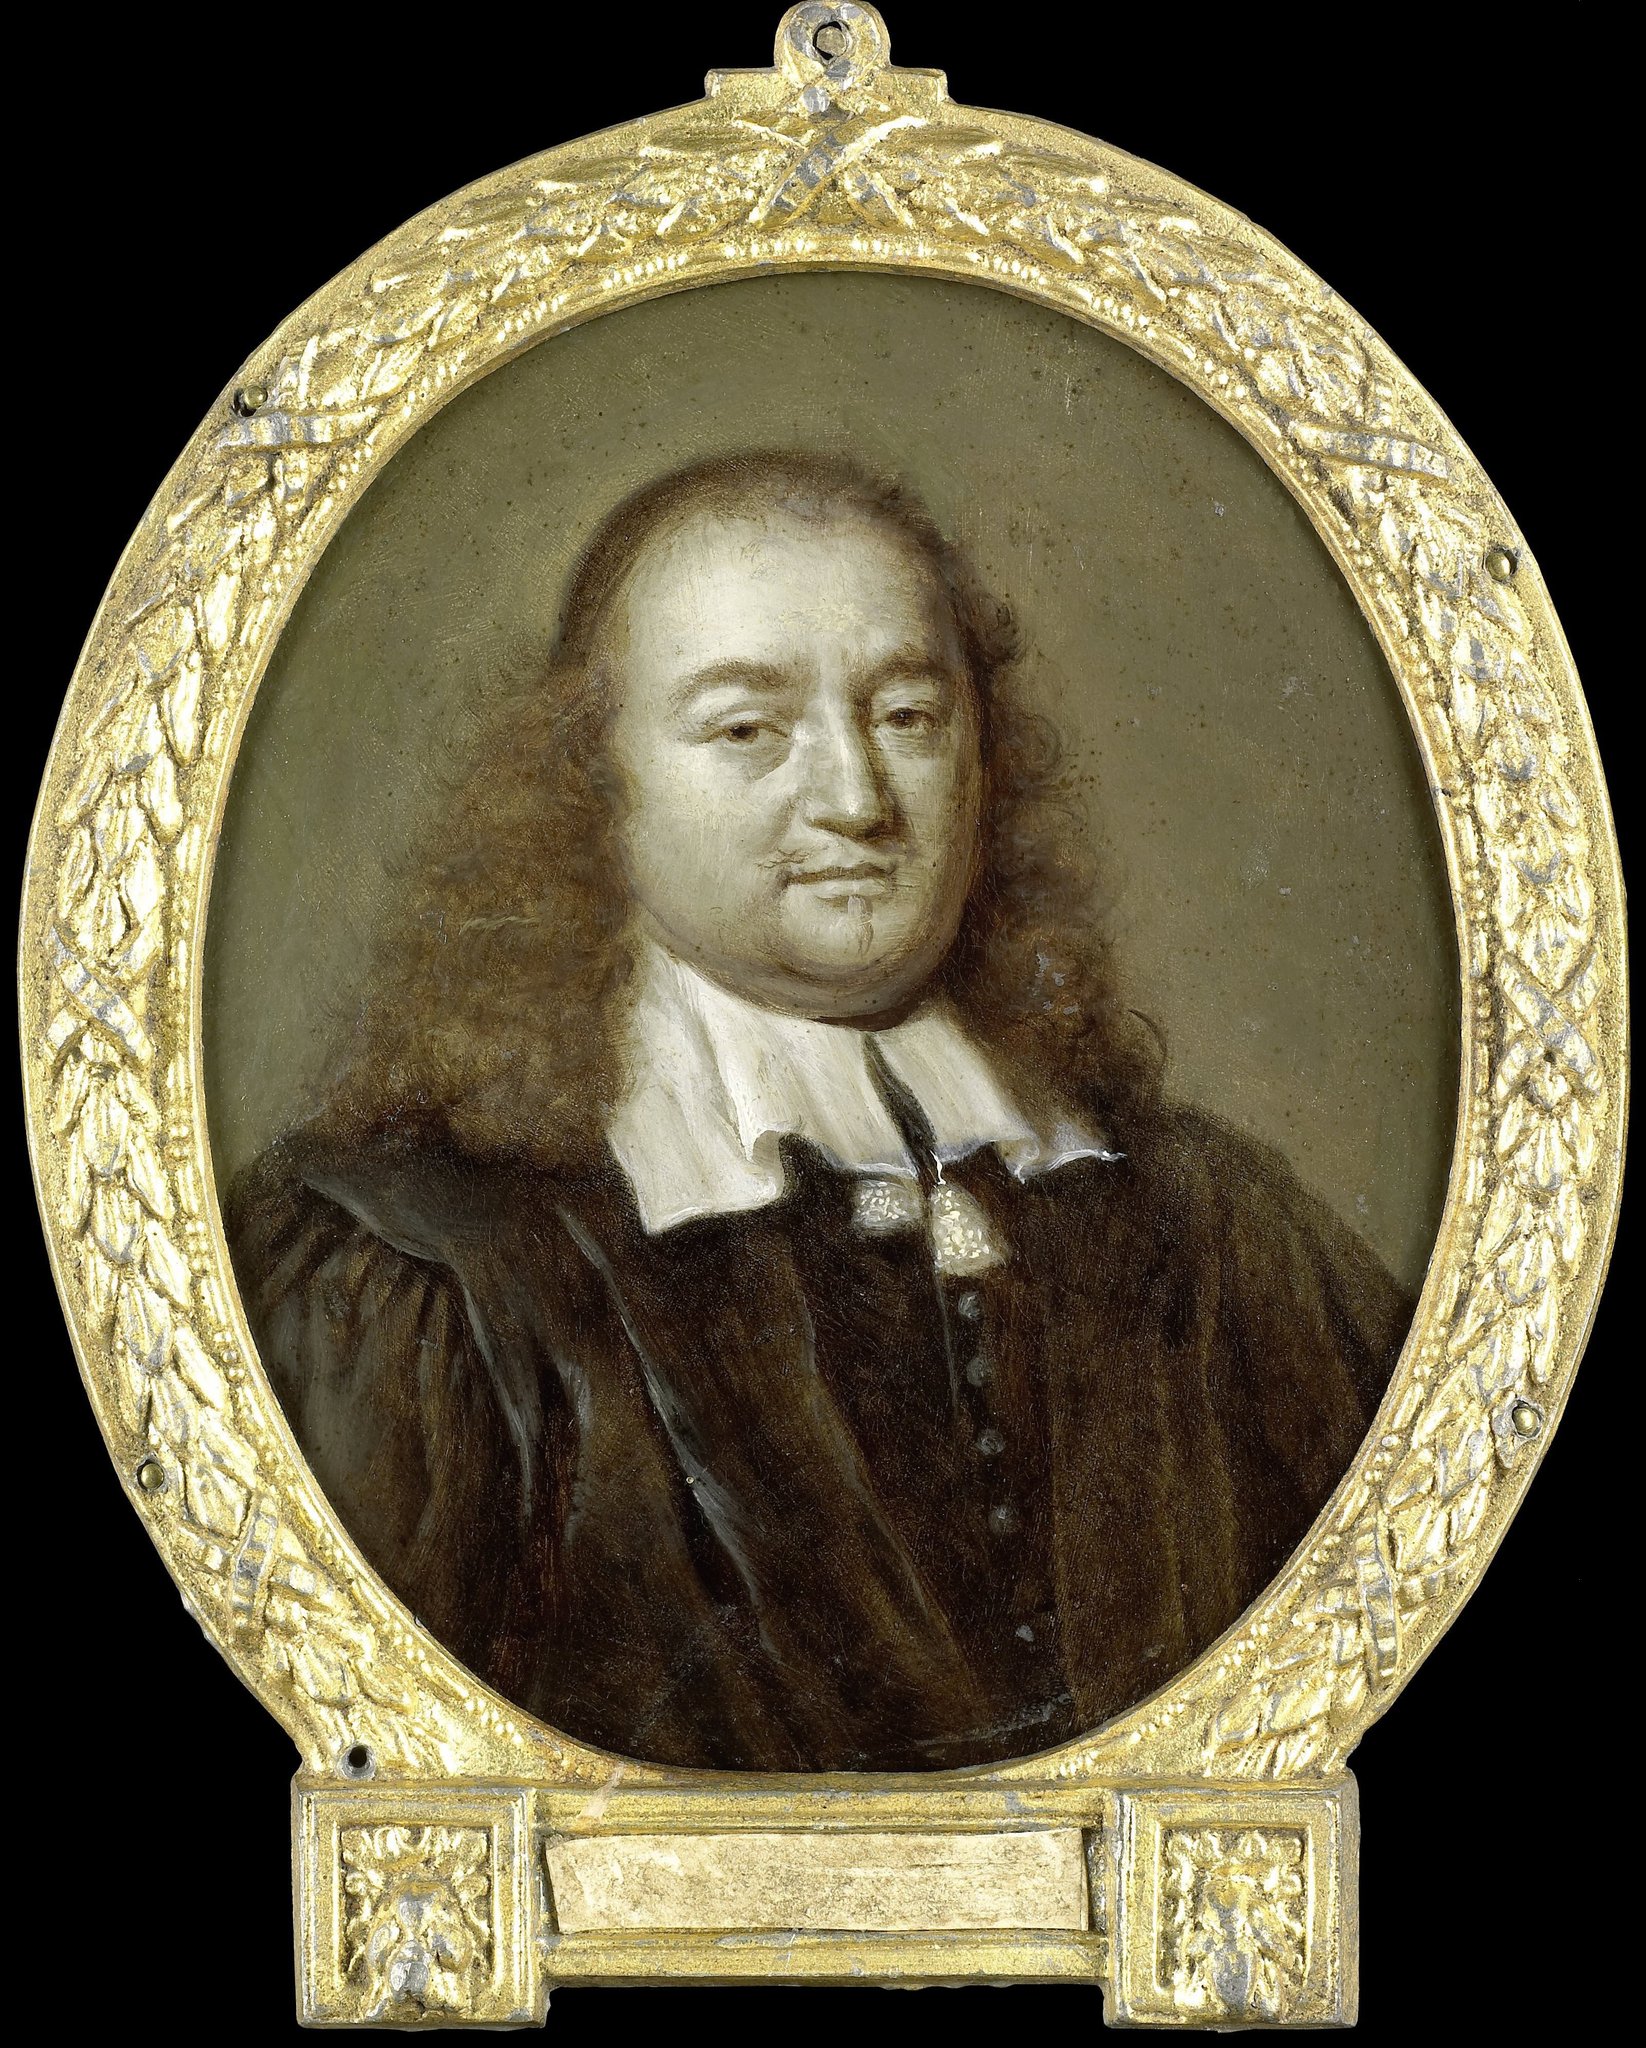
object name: grisaille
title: Portrait of Joannes Fredericus Gronovius, Philologist and Jurist, Professor in Leiden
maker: jan maurits quinkhard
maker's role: draughtsman, painter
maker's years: 1688-1772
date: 1732-1771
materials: copper, oil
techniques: grisaille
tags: leiden, johann friedrich gronovius, portrait of a writer, writer, poet, author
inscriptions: inscription: ‘Joh. Fred.r Gronovius. 1611’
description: Portret van Johan Frederik Gronovius (1611-71). Filoloog en jurist, hoogleraar te Leiden. Buste in ovaal, naar rechts. Onderdeel van een verzameling portretten van Nederlandse dichters.